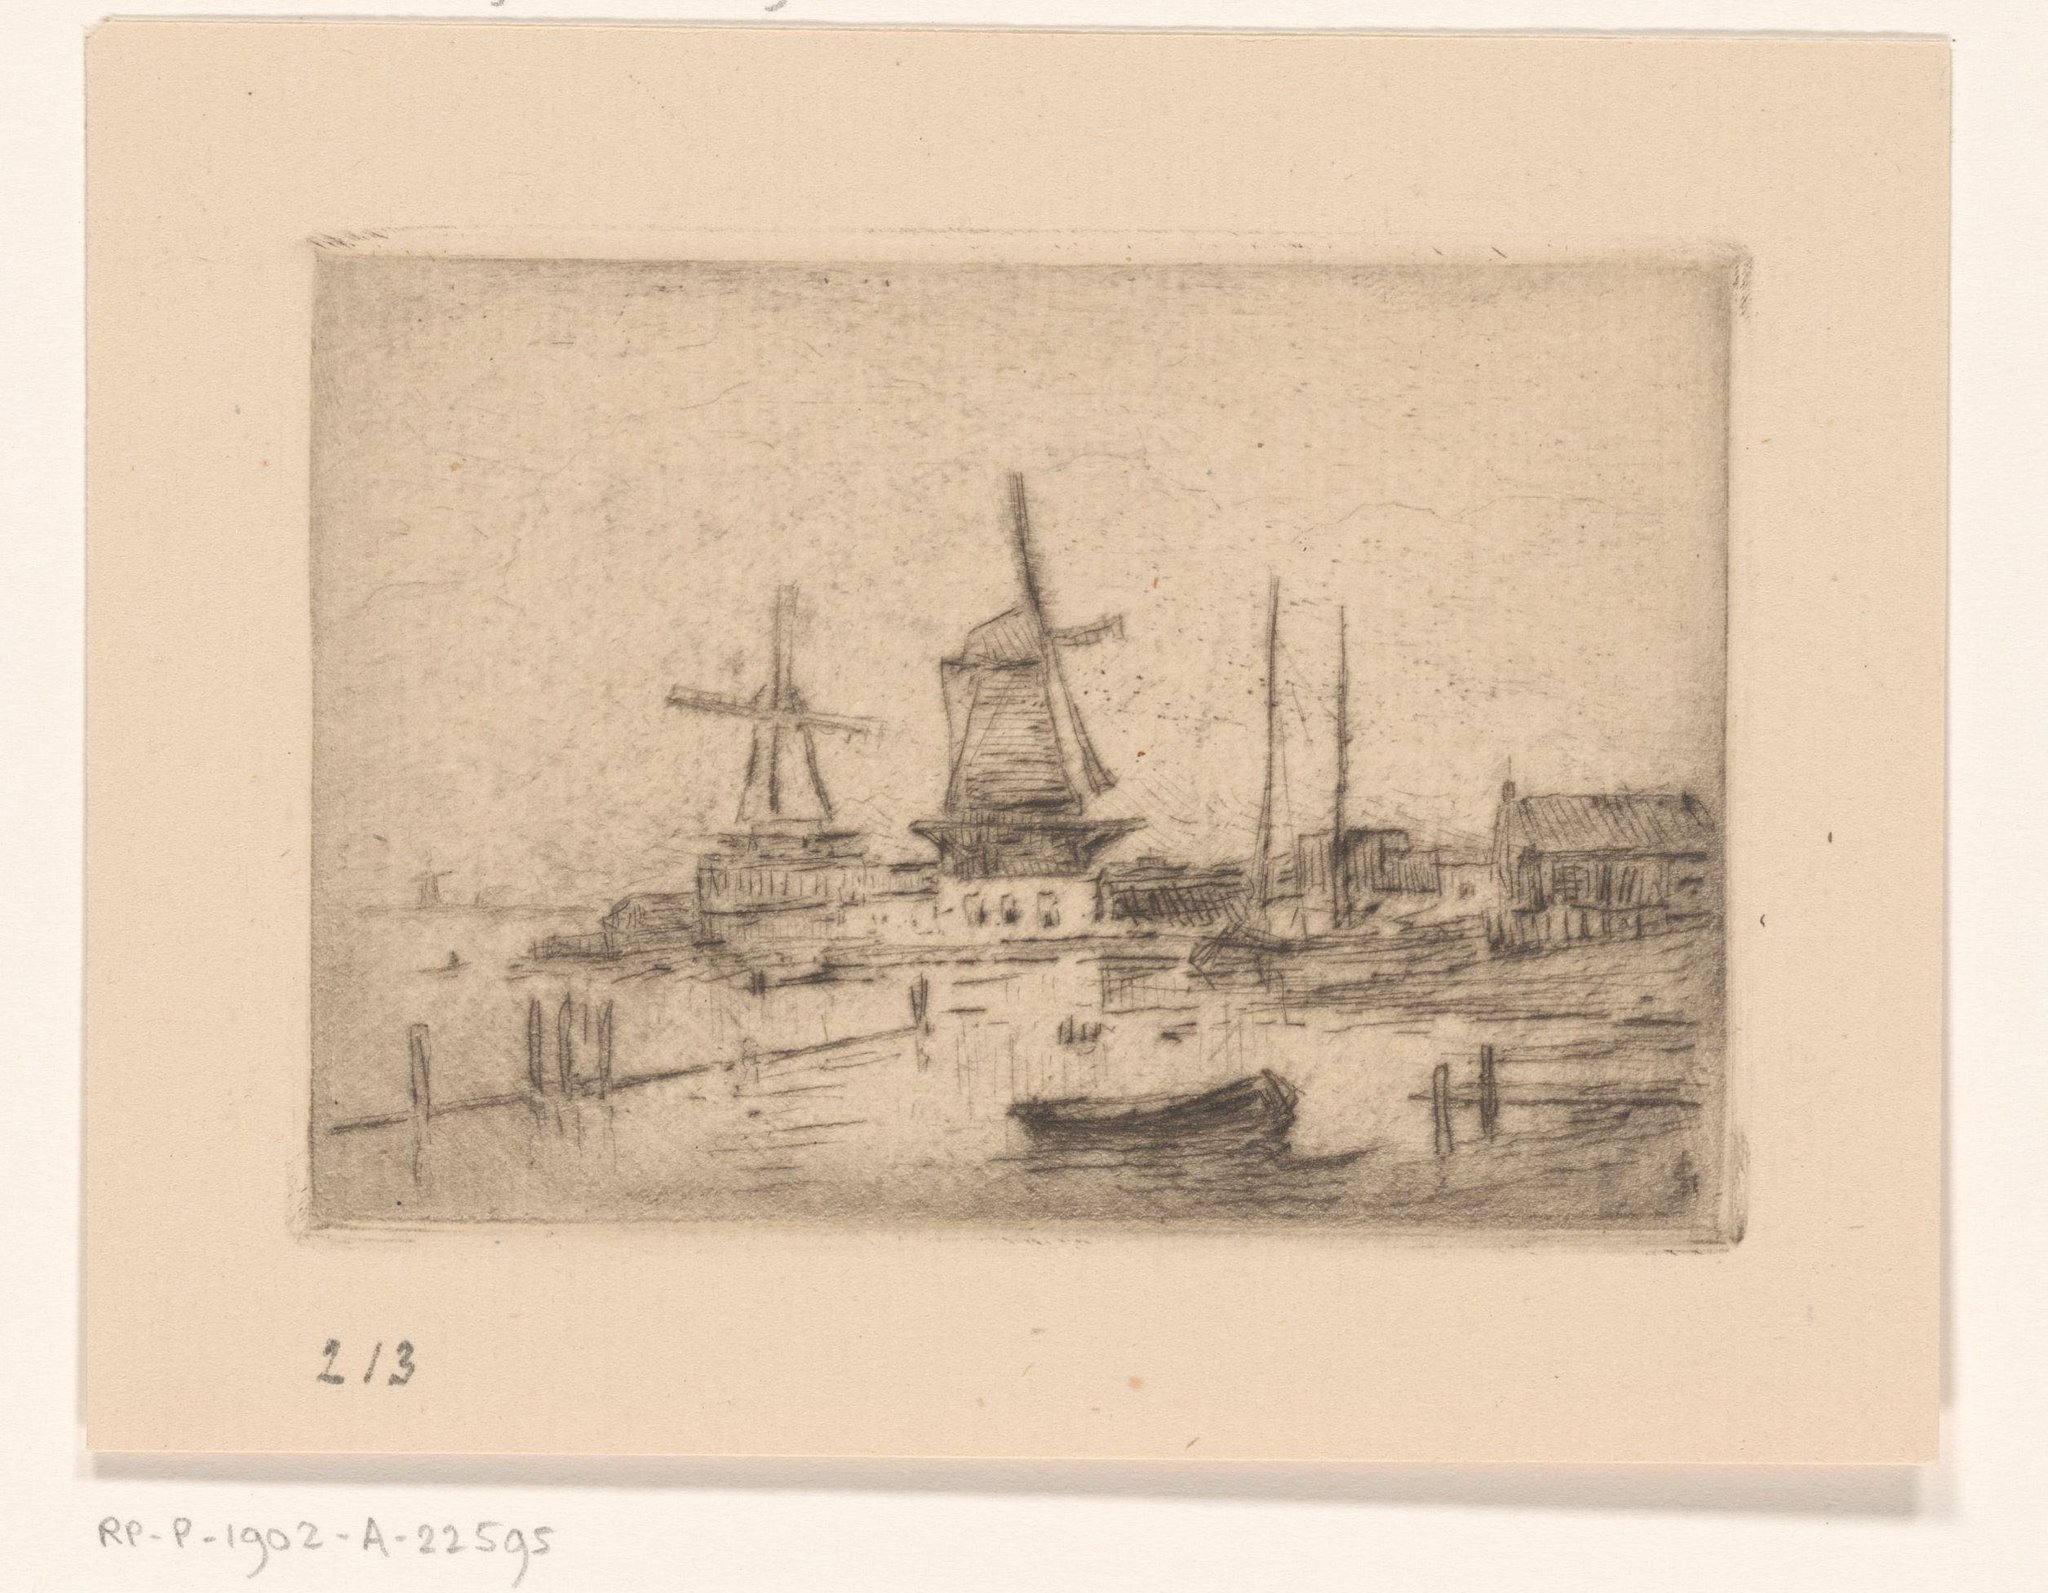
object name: print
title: Molens bij Dordrecht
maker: carel nicolaas storm van s-gravesande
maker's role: draughtsman, print maker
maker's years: 1841-1924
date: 1884-1887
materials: paper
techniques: drypoint, intaglio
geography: netherlands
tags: windmill in landscape, dordrecht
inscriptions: collector's mark: Lugt 2228